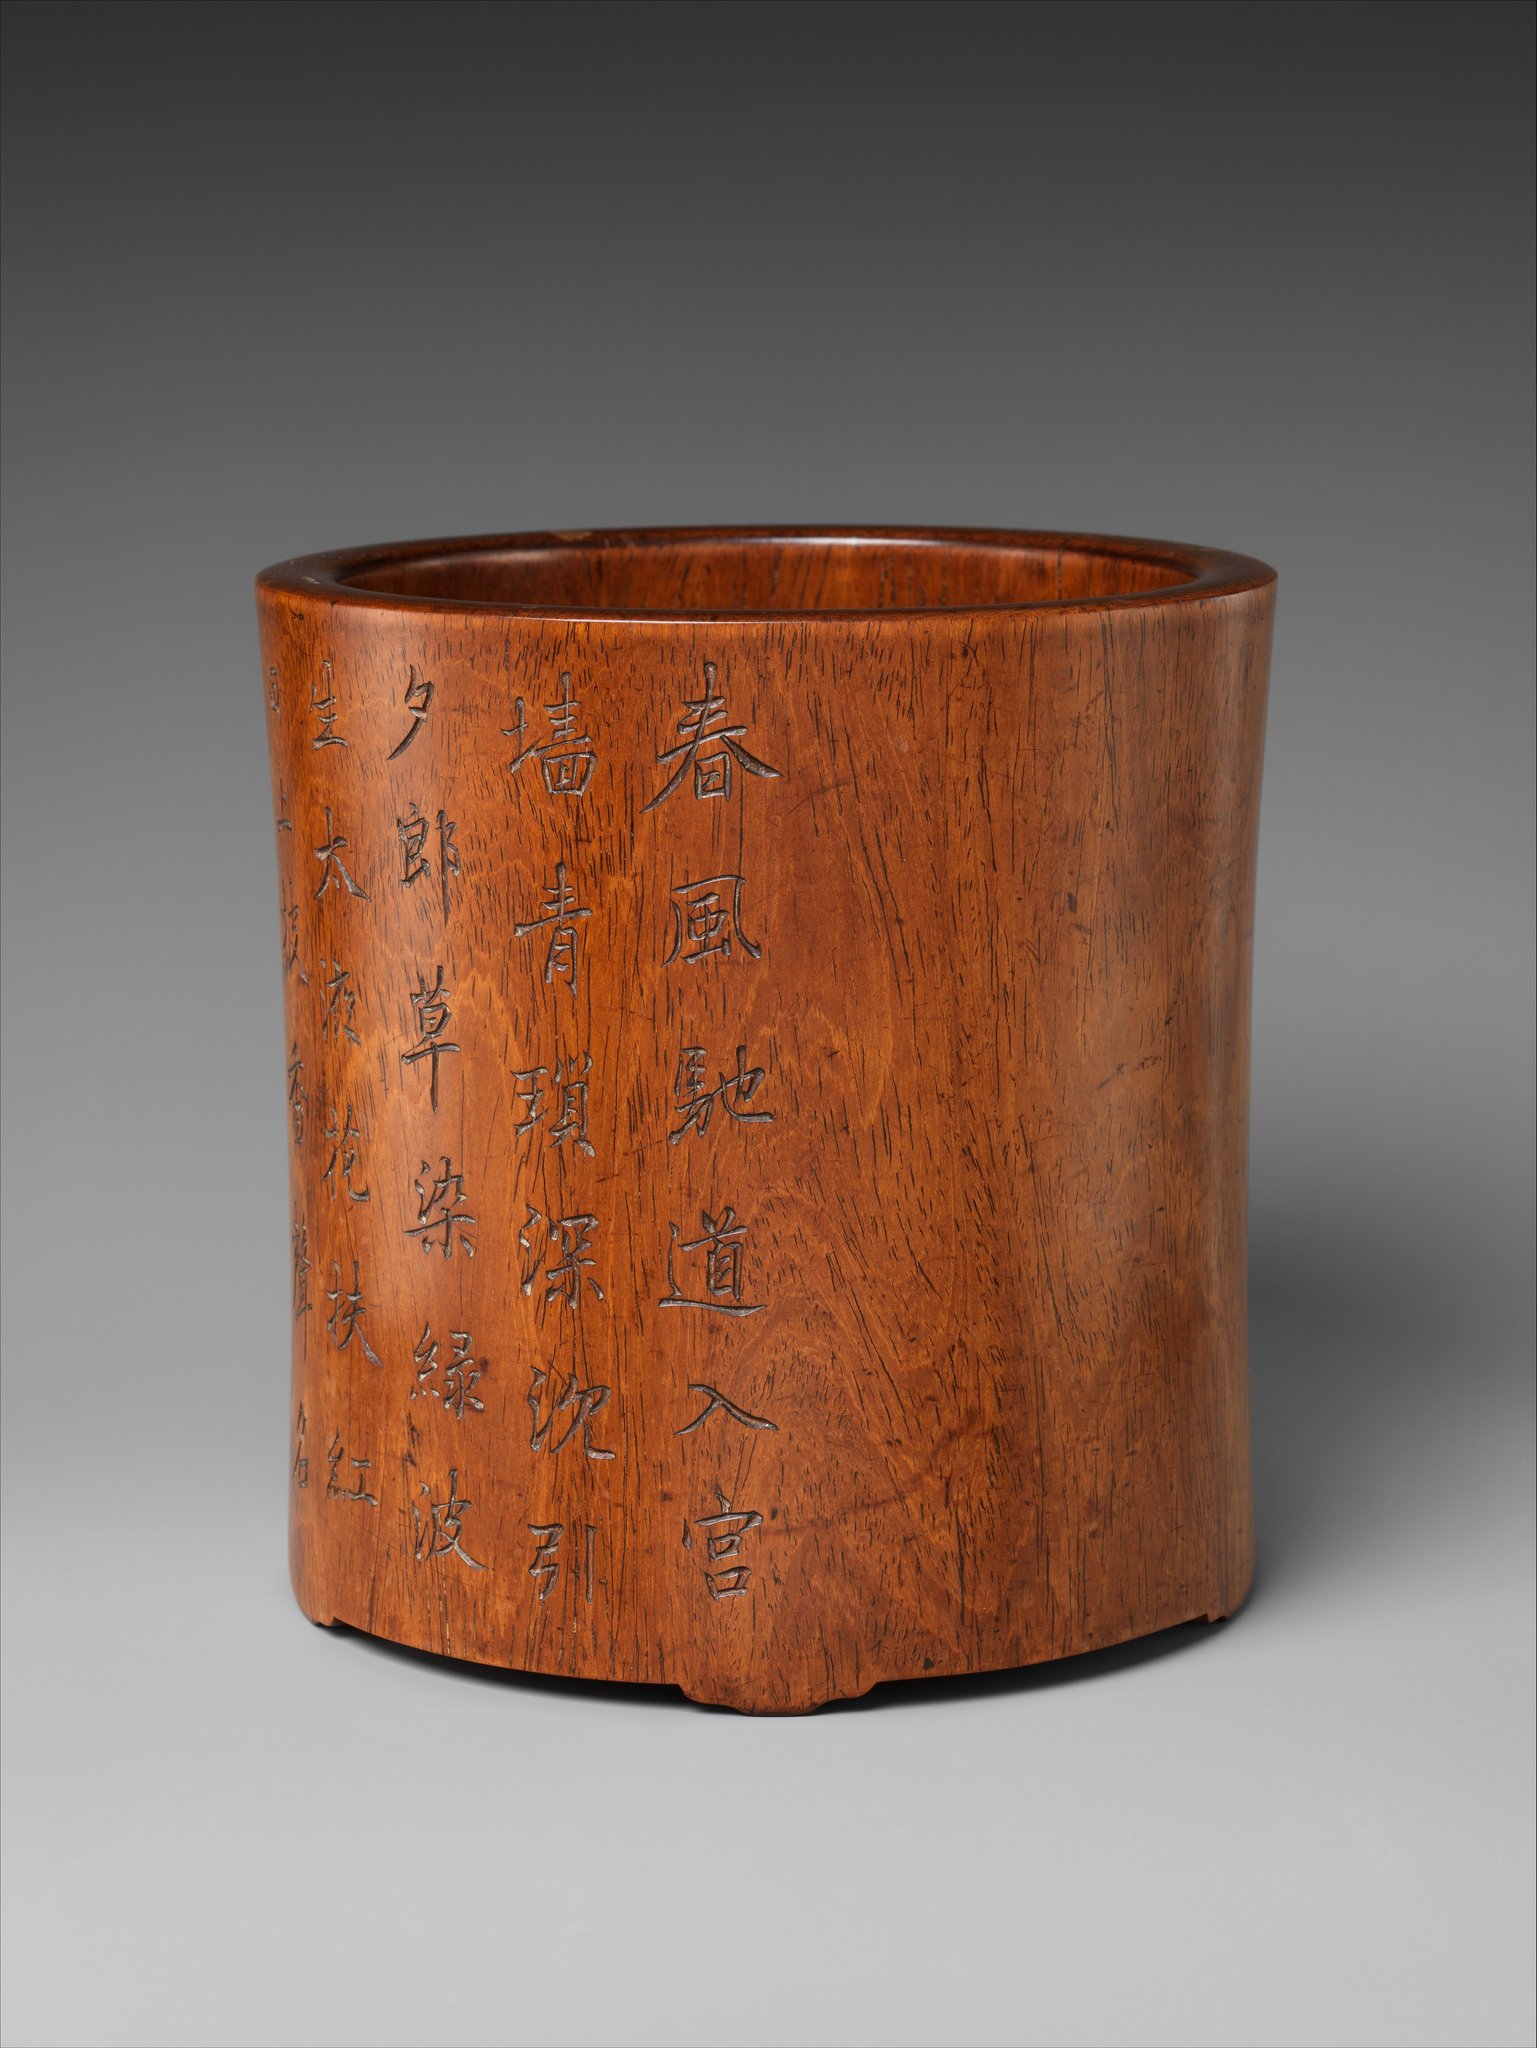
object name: brush pot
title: Brush pot with poem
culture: chinese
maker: wang shihong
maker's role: artist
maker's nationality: chinese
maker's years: 1658-1723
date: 1716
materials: wood